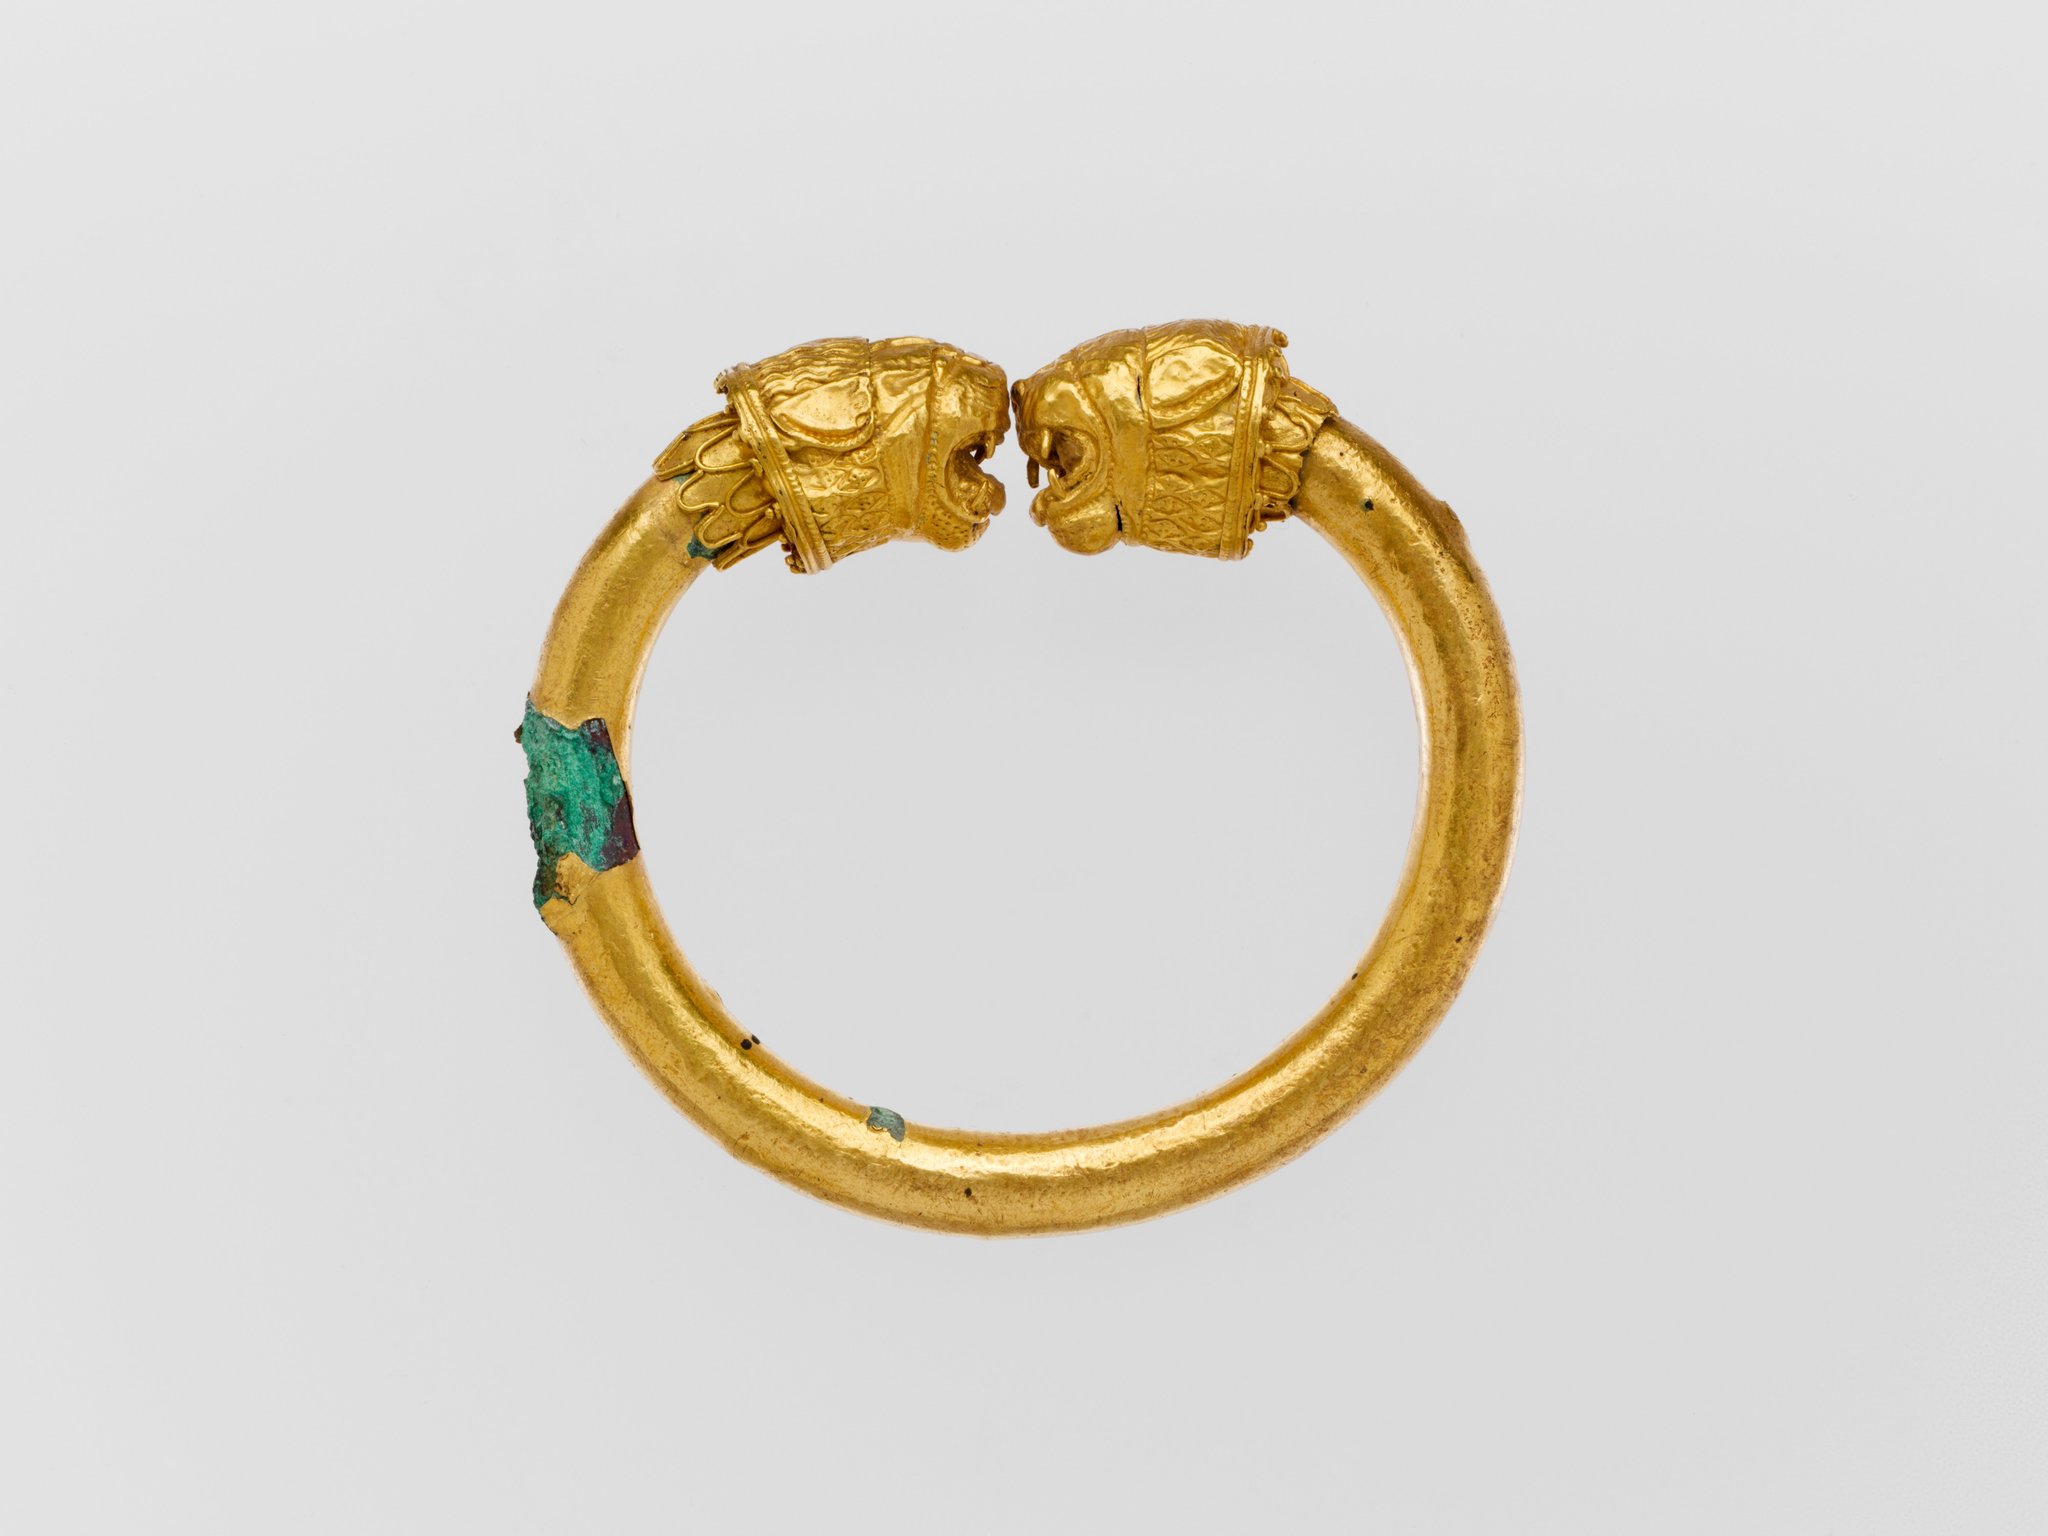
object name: bracelet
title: Gold and copper alloy bracelet with lion-head finials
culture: cypriot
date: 500-401 BCE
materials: copper alloy, gold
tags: lions